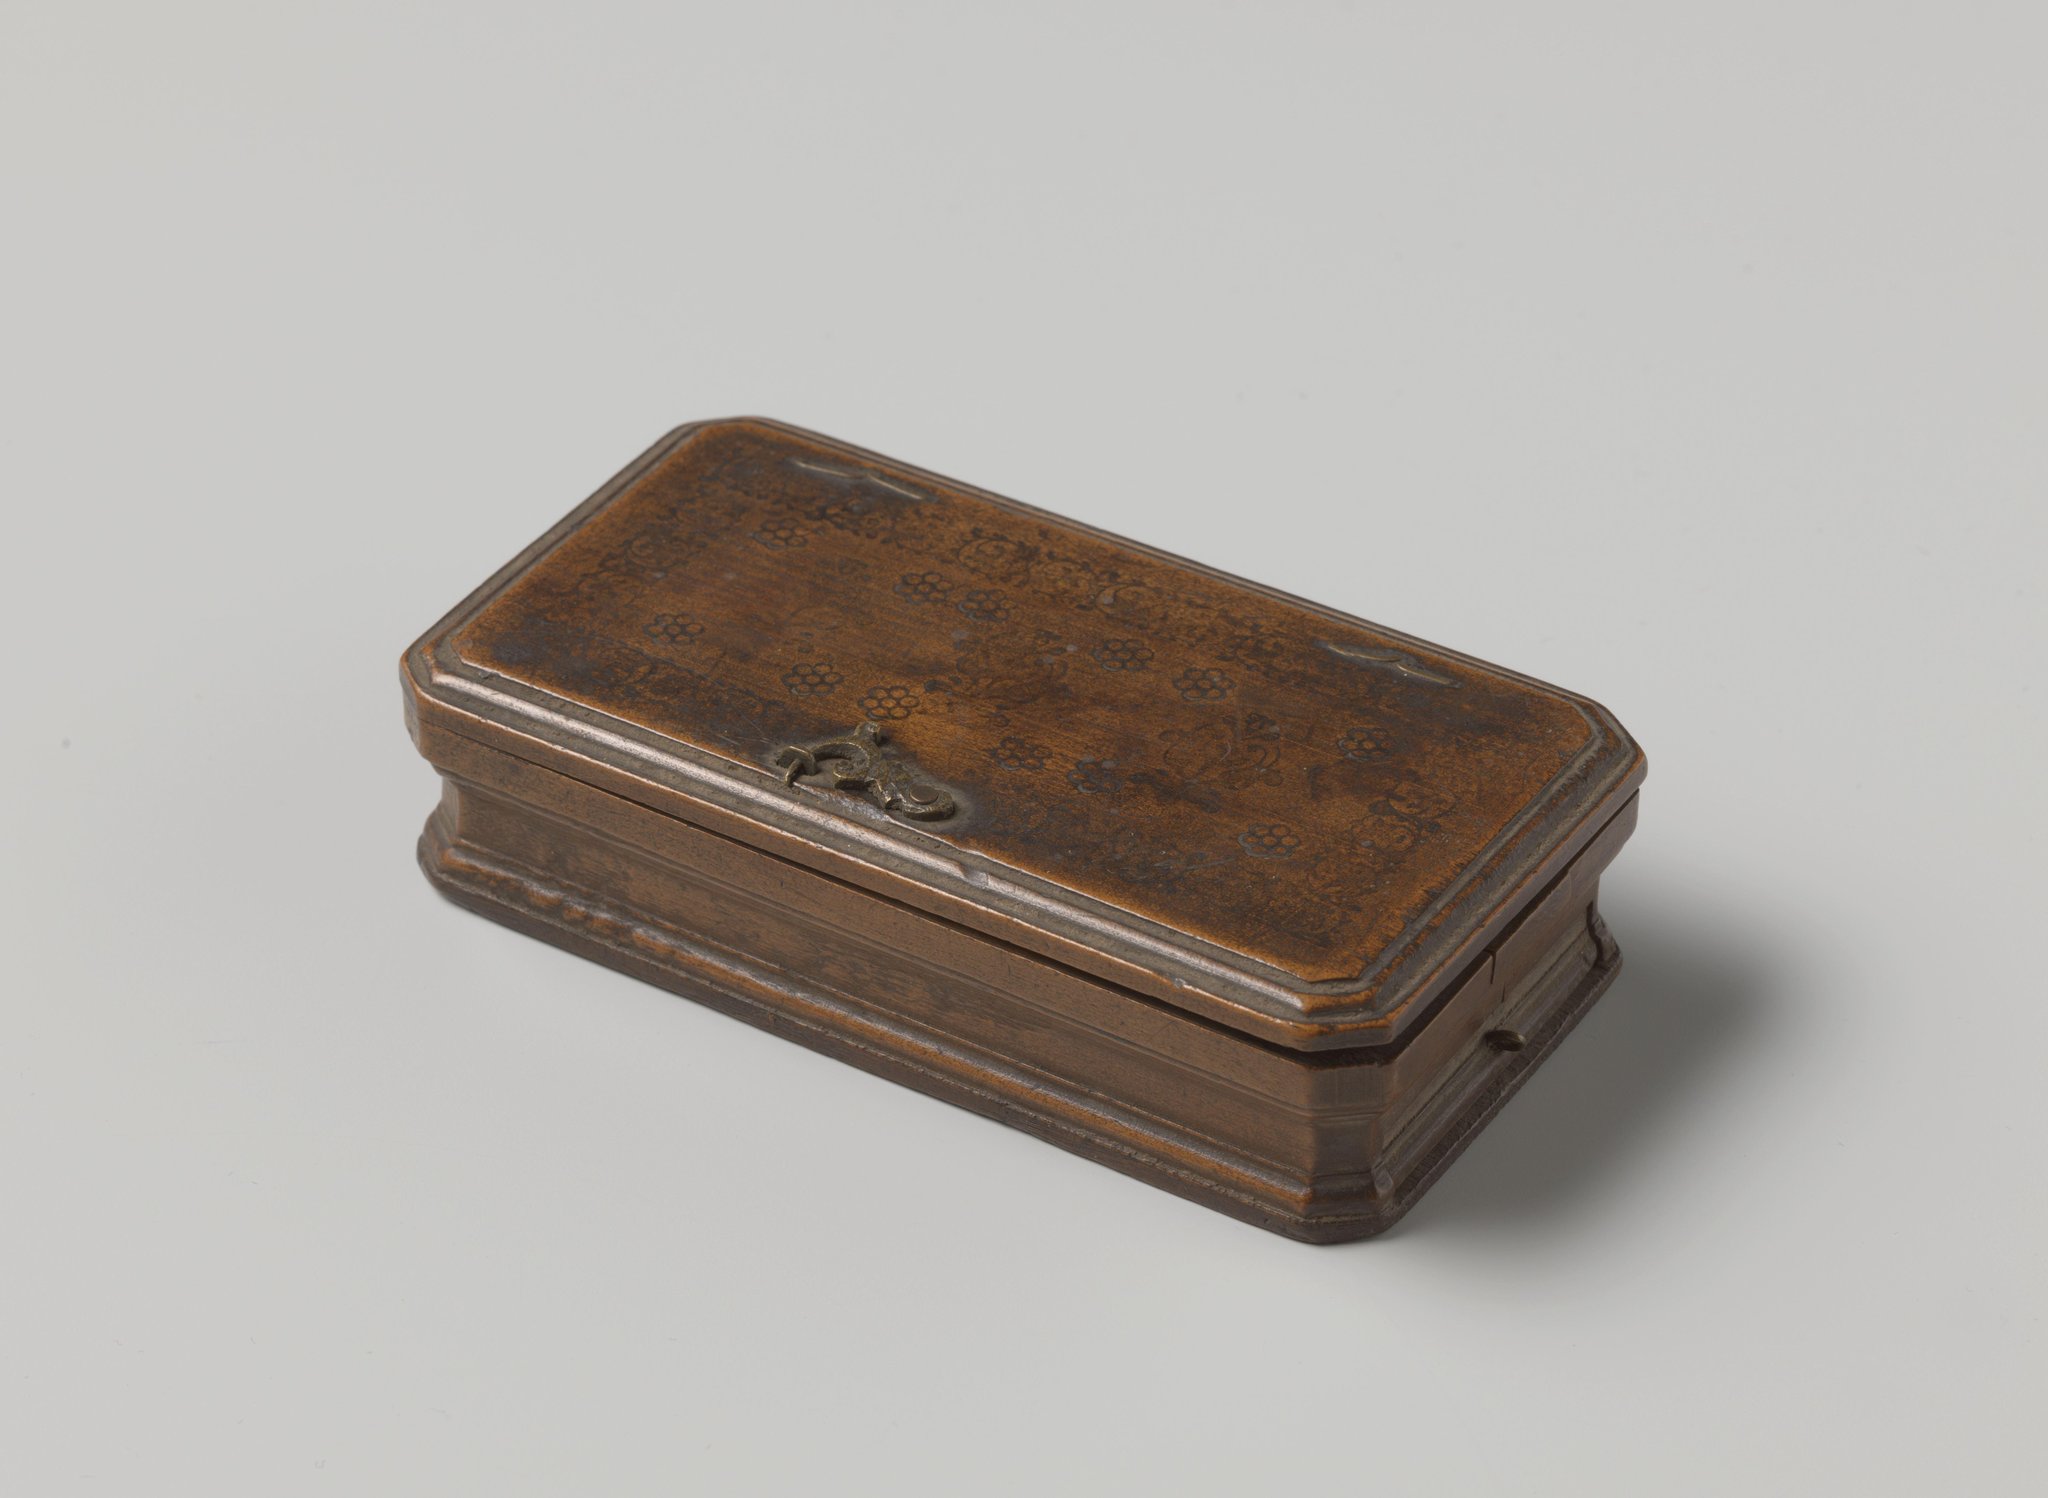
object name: balance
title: Muntgewichtdoos met muntgewichten, greingewichten, stift en balans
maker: johannes linderman (ii)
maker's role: balansmaker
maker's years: 1700-1758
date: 1720-1758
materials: copper, wood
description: Houten doos met onderlade, waarin 21 messing muntgewichten (allemaal gemerkt met het stadswapenschild Amsterdam tussen L - M, met een punt op de L), 5 greingewichten, stift en balans. De deksel is aan de binnenkant versierd met een etiket met voorstellingen van muntgewichten, met in het midden het gekroonde wapenschild van Amsterdam waaronder een gebruiker van de muntgewichtdoos die opschrikt terwijl de Dood zijn goud wegneemt